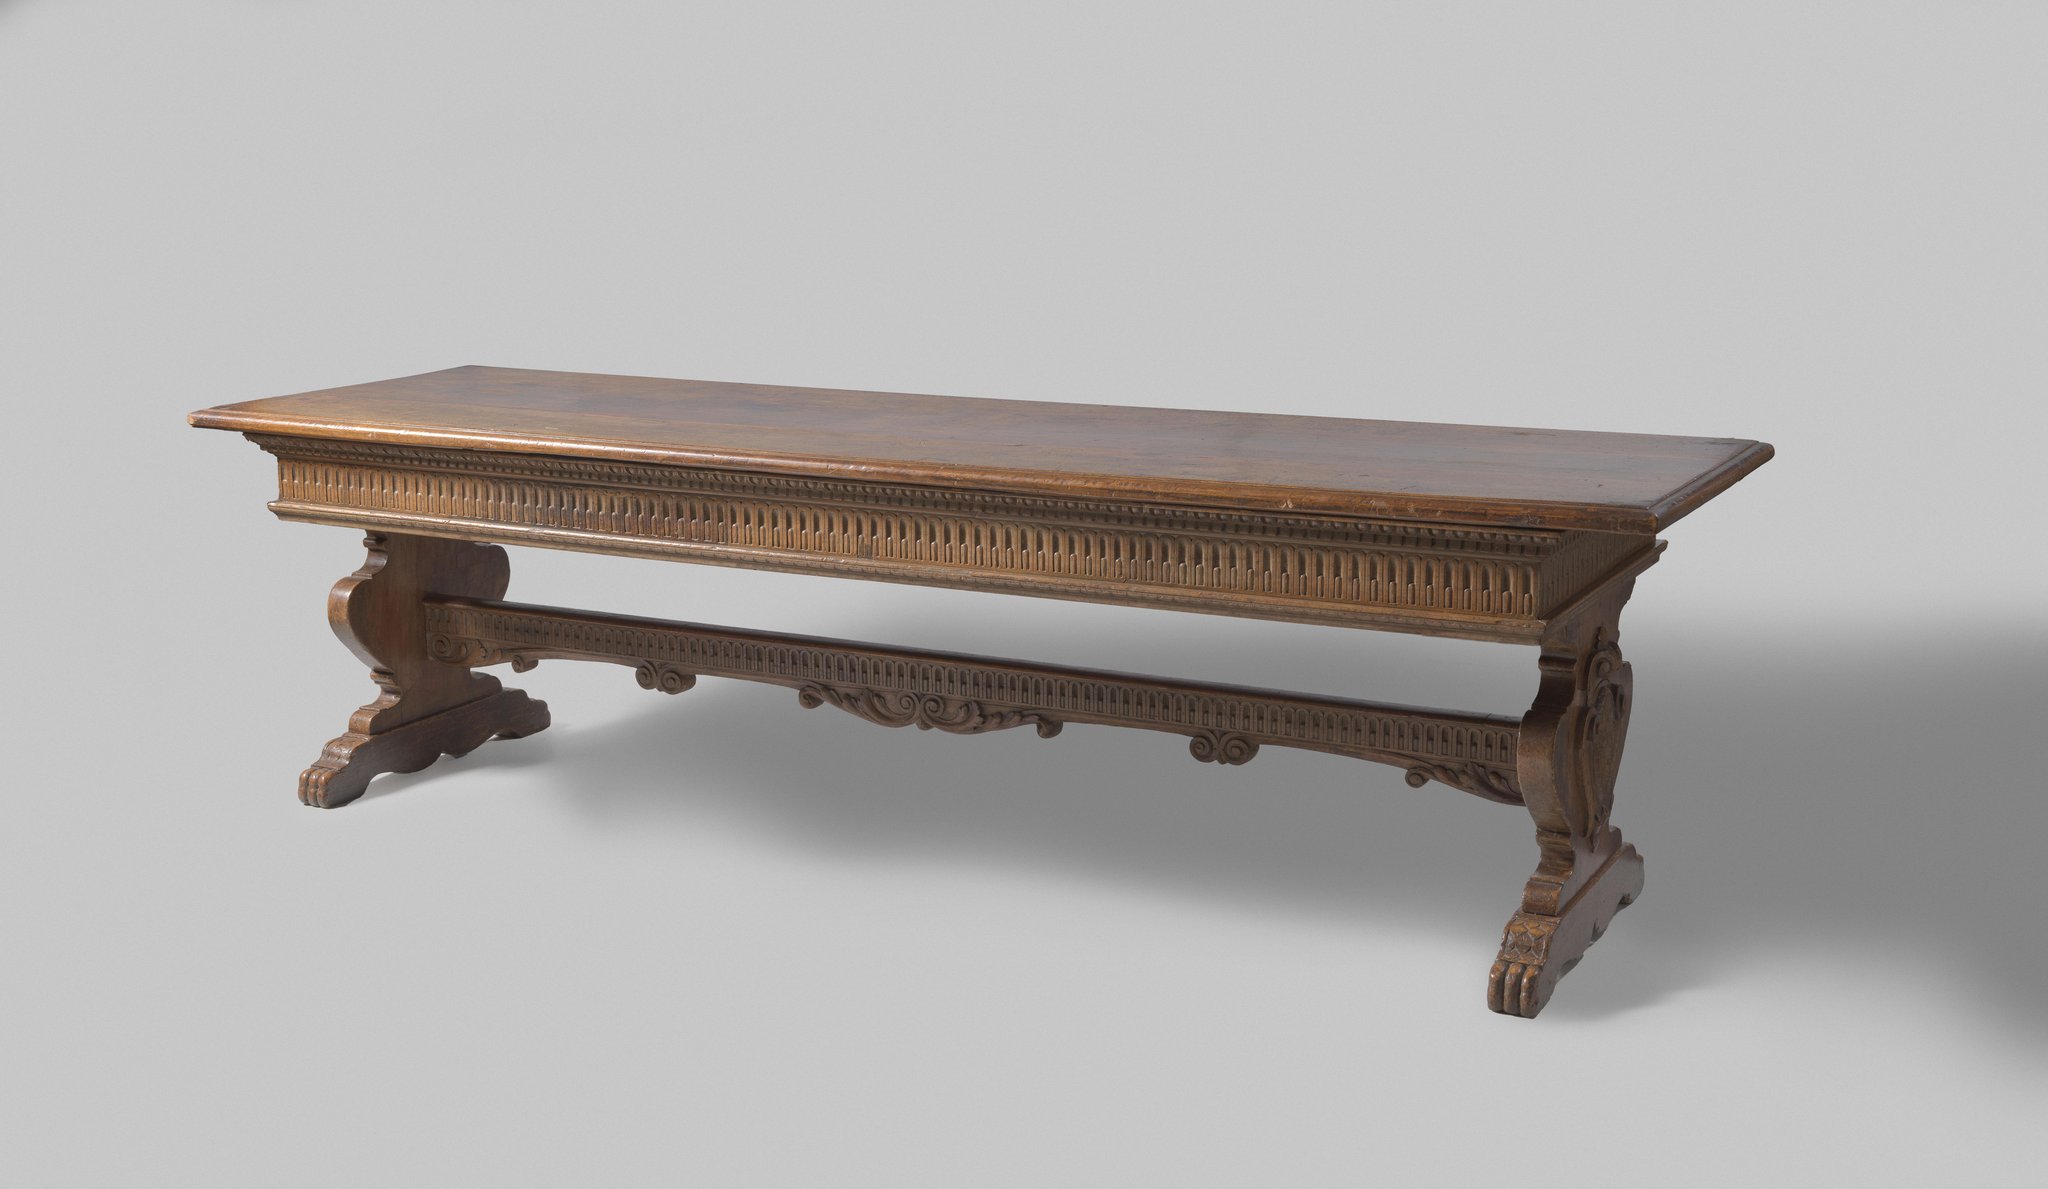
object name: table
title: Wangentafel met het wapenschild van het geslacht Piccolomini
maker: Anonymous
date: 1550-1600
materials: copper, wood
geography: italy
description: Table. Walnut, carved with the arms of the Piccolomini family. Italy, c. 1550 - 1600.